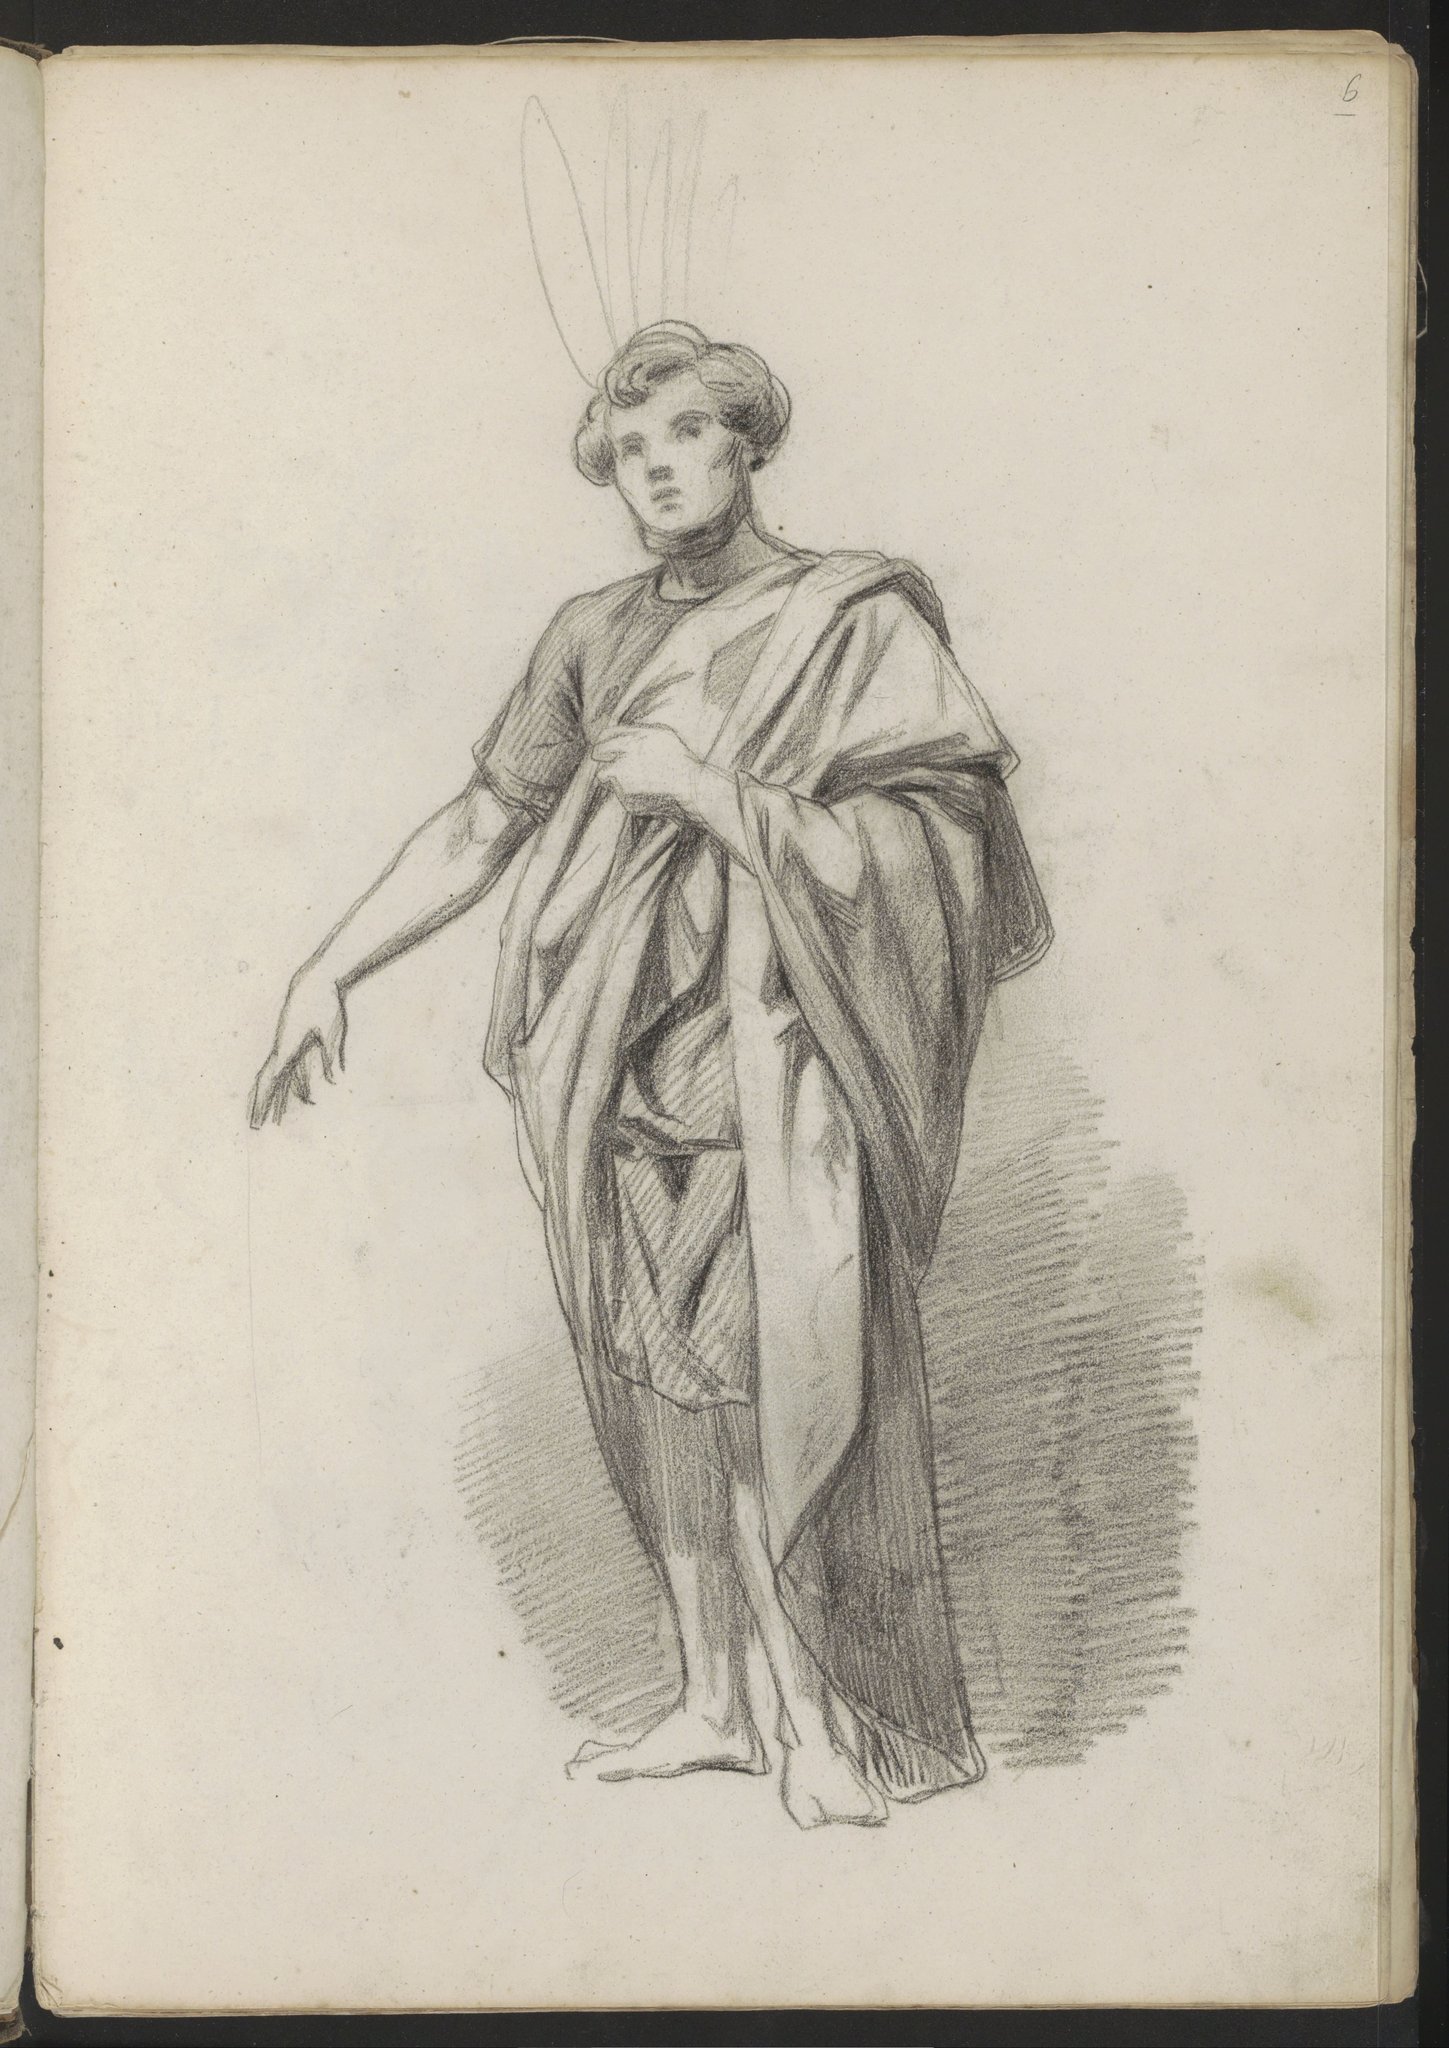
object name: sketchbook leaf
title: Man in een toga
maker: johannes huybertus van hove bzn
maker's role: print maker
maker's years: 1827-1881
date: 1837-1881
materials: chalk, paper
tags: standing figure, clothes, costume (+ men's clothes)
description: Blad 6 recto uit een schetsboek met 33 bladen en 10 losse tekeningen.